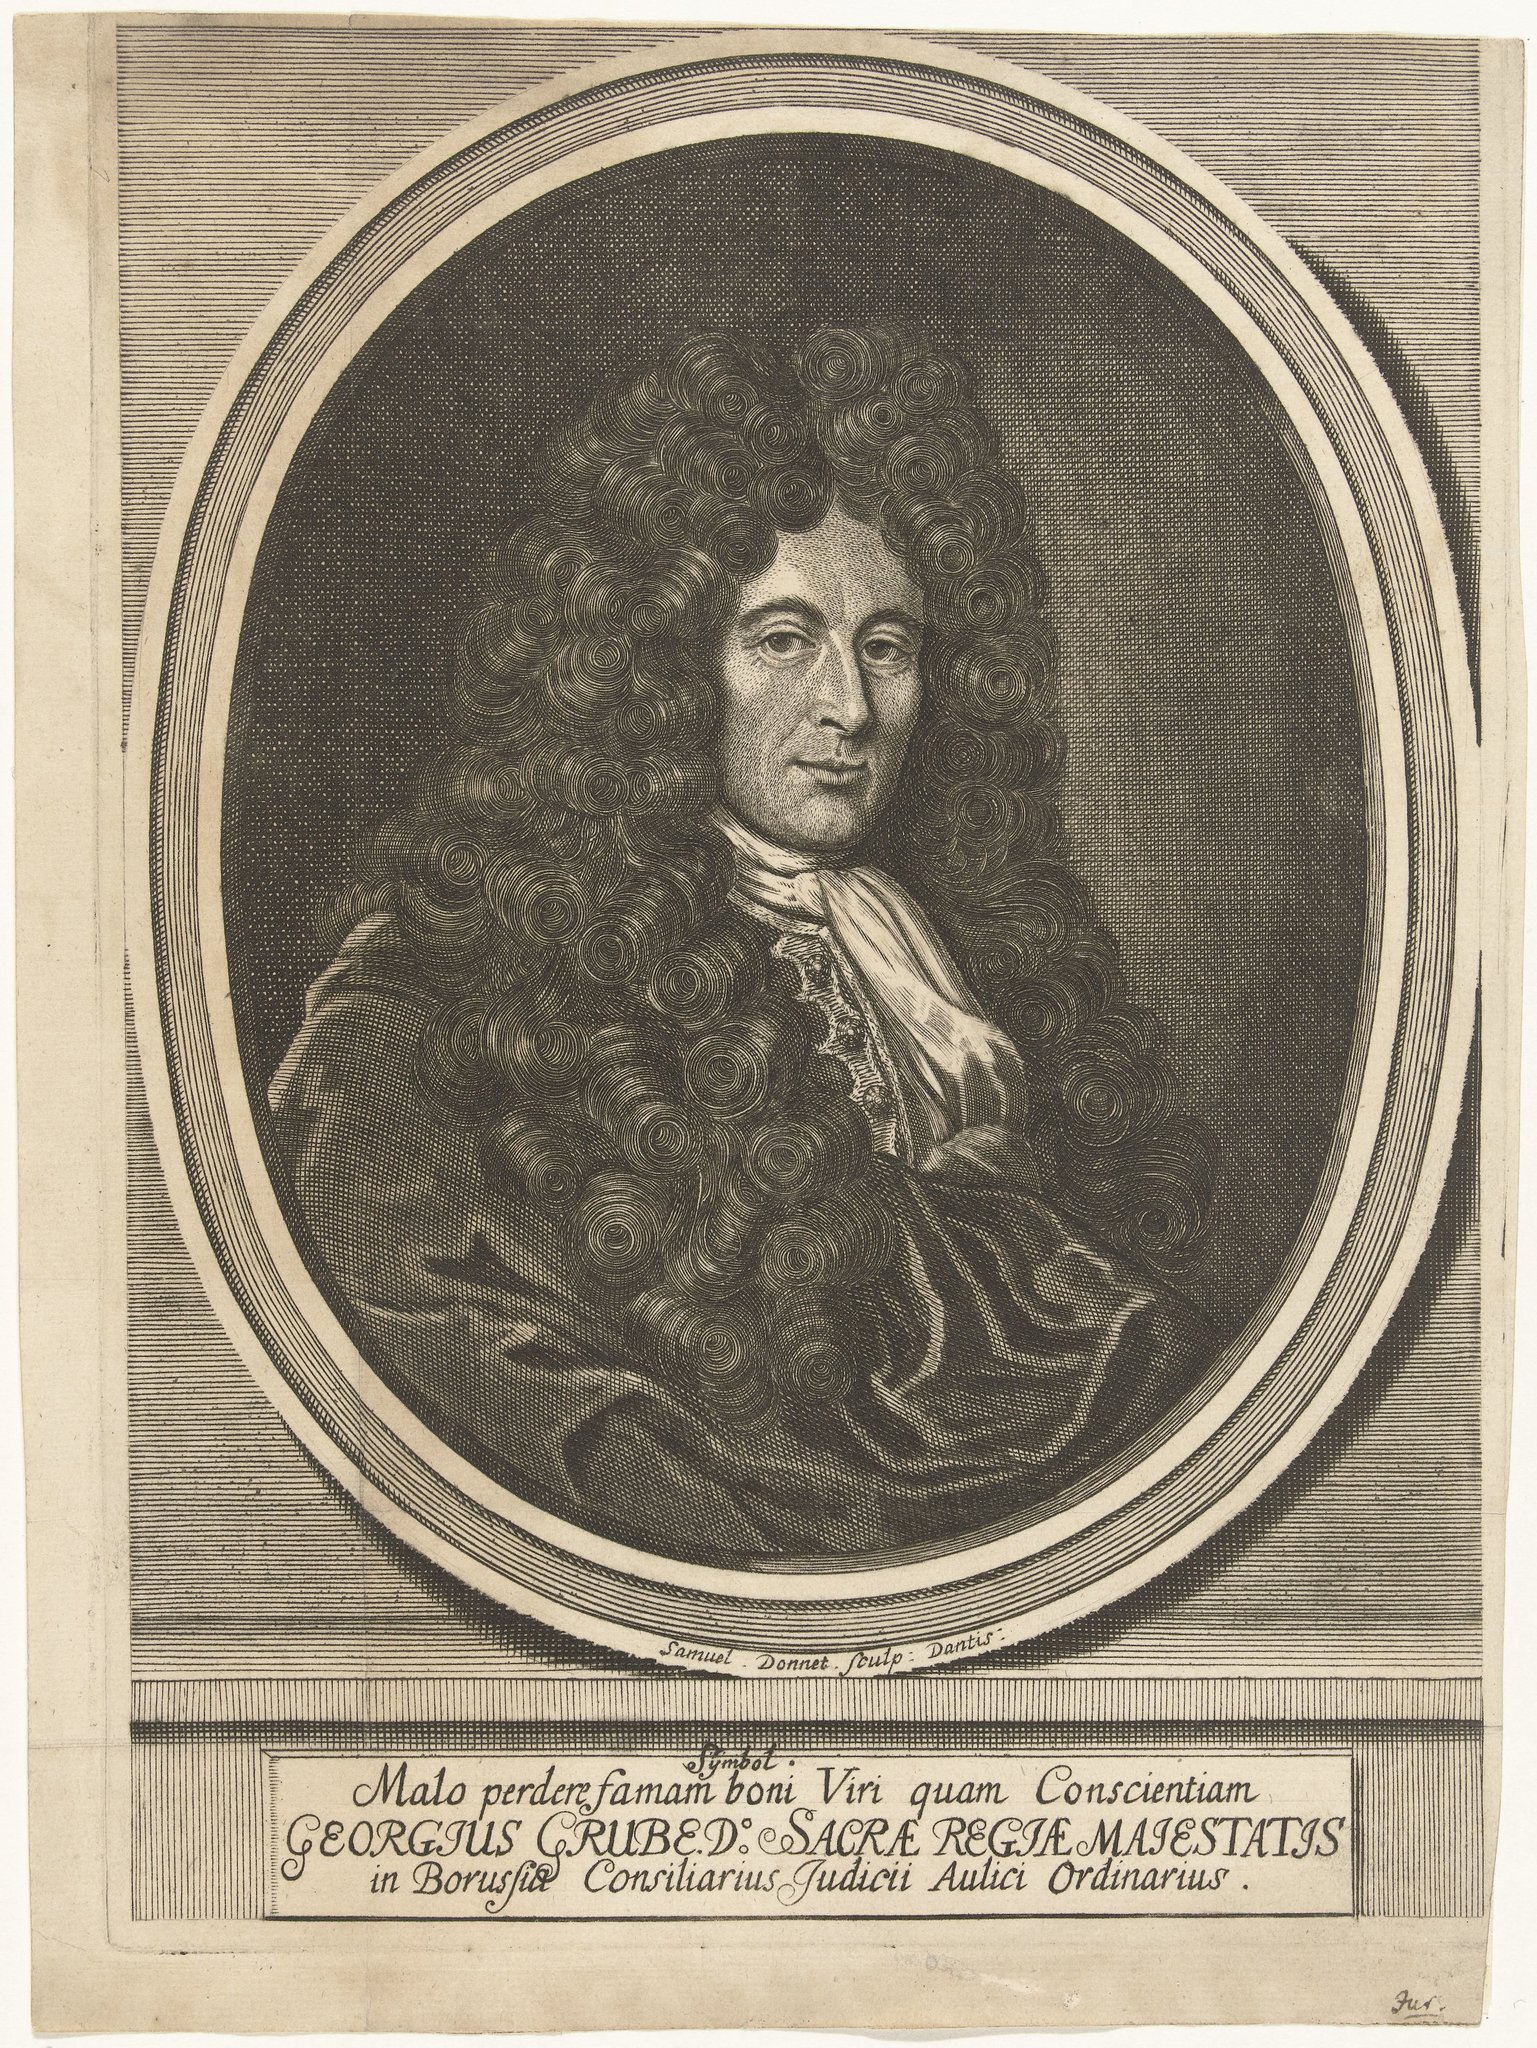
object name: print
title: Portret van Georg Grube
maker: samuel donnet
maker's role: print maker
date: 1699-1734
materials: paper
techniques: engraving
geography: gdansk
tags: georg grube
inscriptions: collector's mark: Lugt 2228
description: Portret van Georg Grube, Pruisisch ambtenaar, in ovaal. Onder het portret zijn naam en functie in het Latijn.